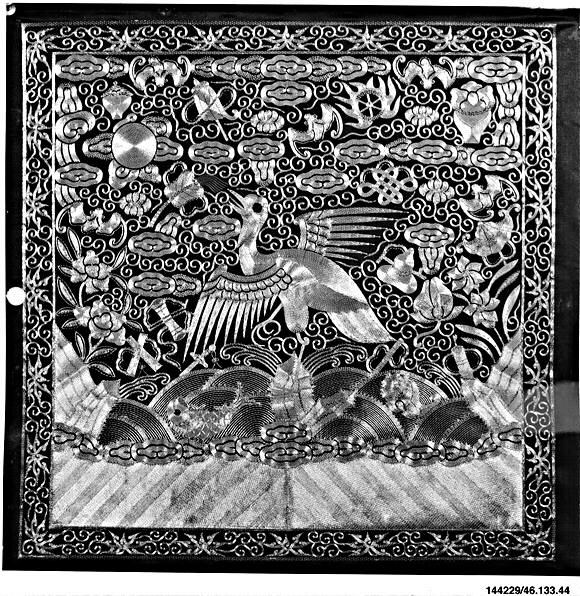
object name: rank badge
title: Rank Badge with Wild Goose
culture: chinese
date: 1767-1833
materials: metal thread, silk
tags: bats,geese